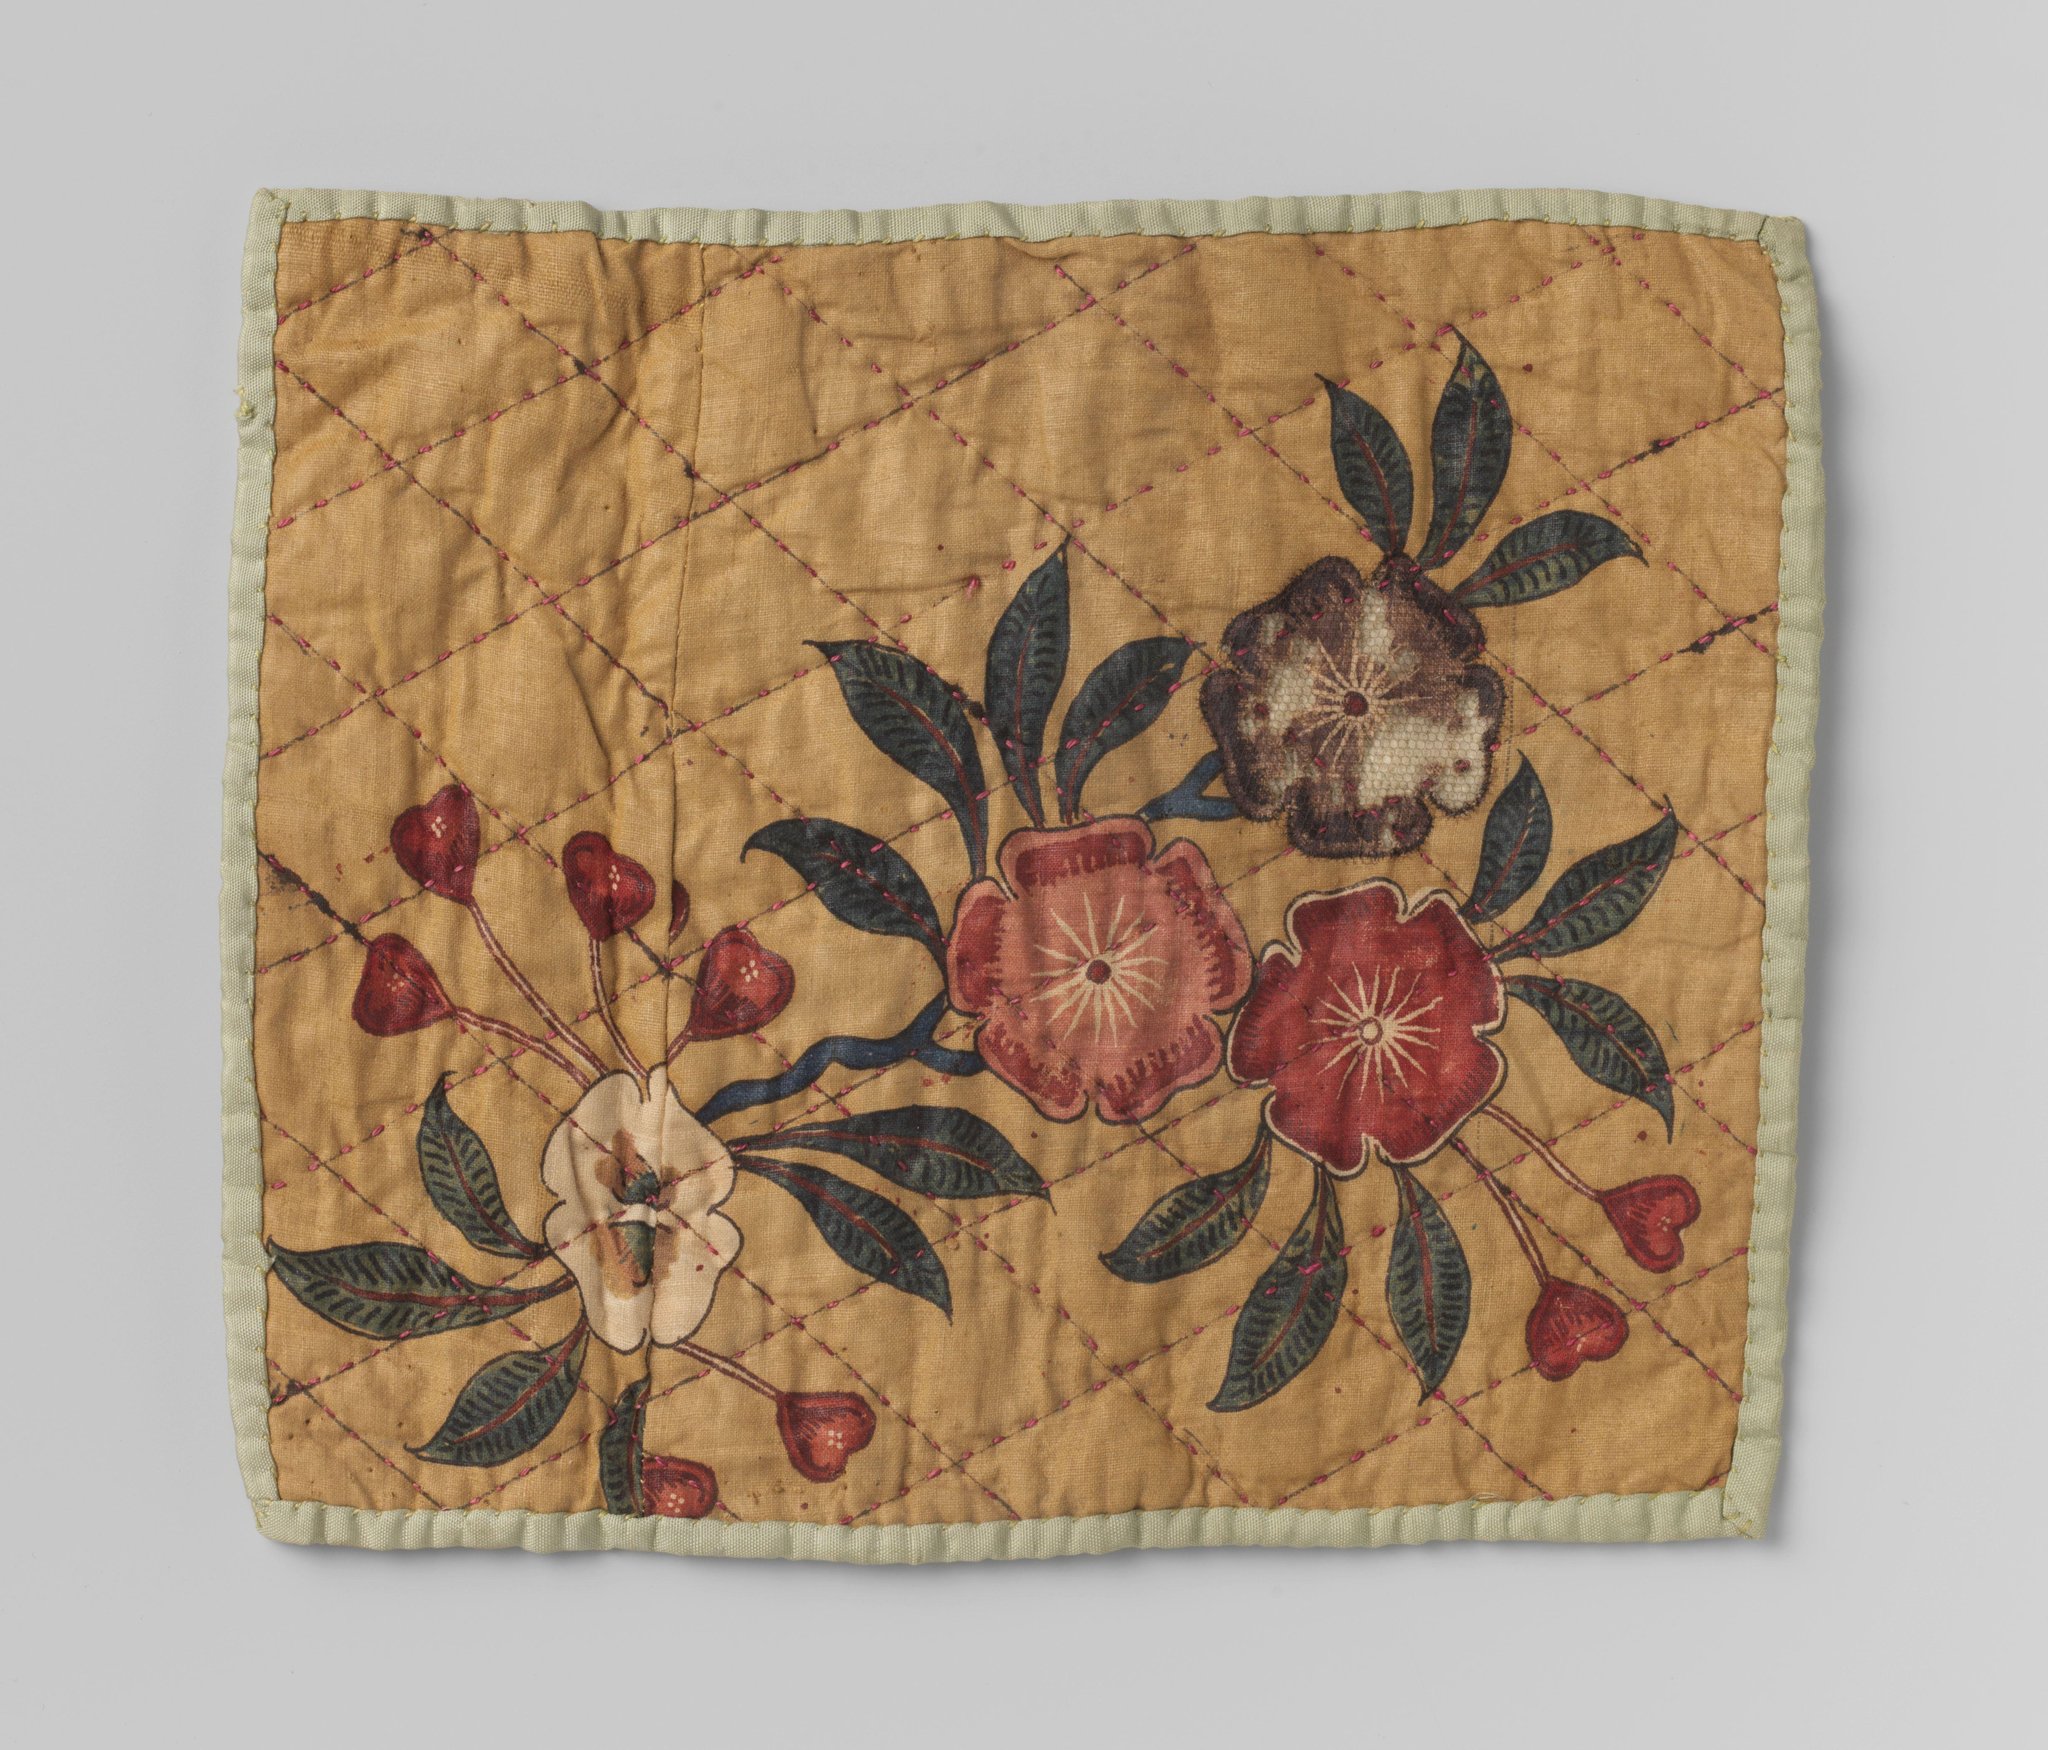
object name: bedspread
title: Deken met bloemmotieven, doorgestikt in ruitpatroon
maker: Anonymous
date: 1750-1800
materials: cotton, silk, wool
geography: amsterdam